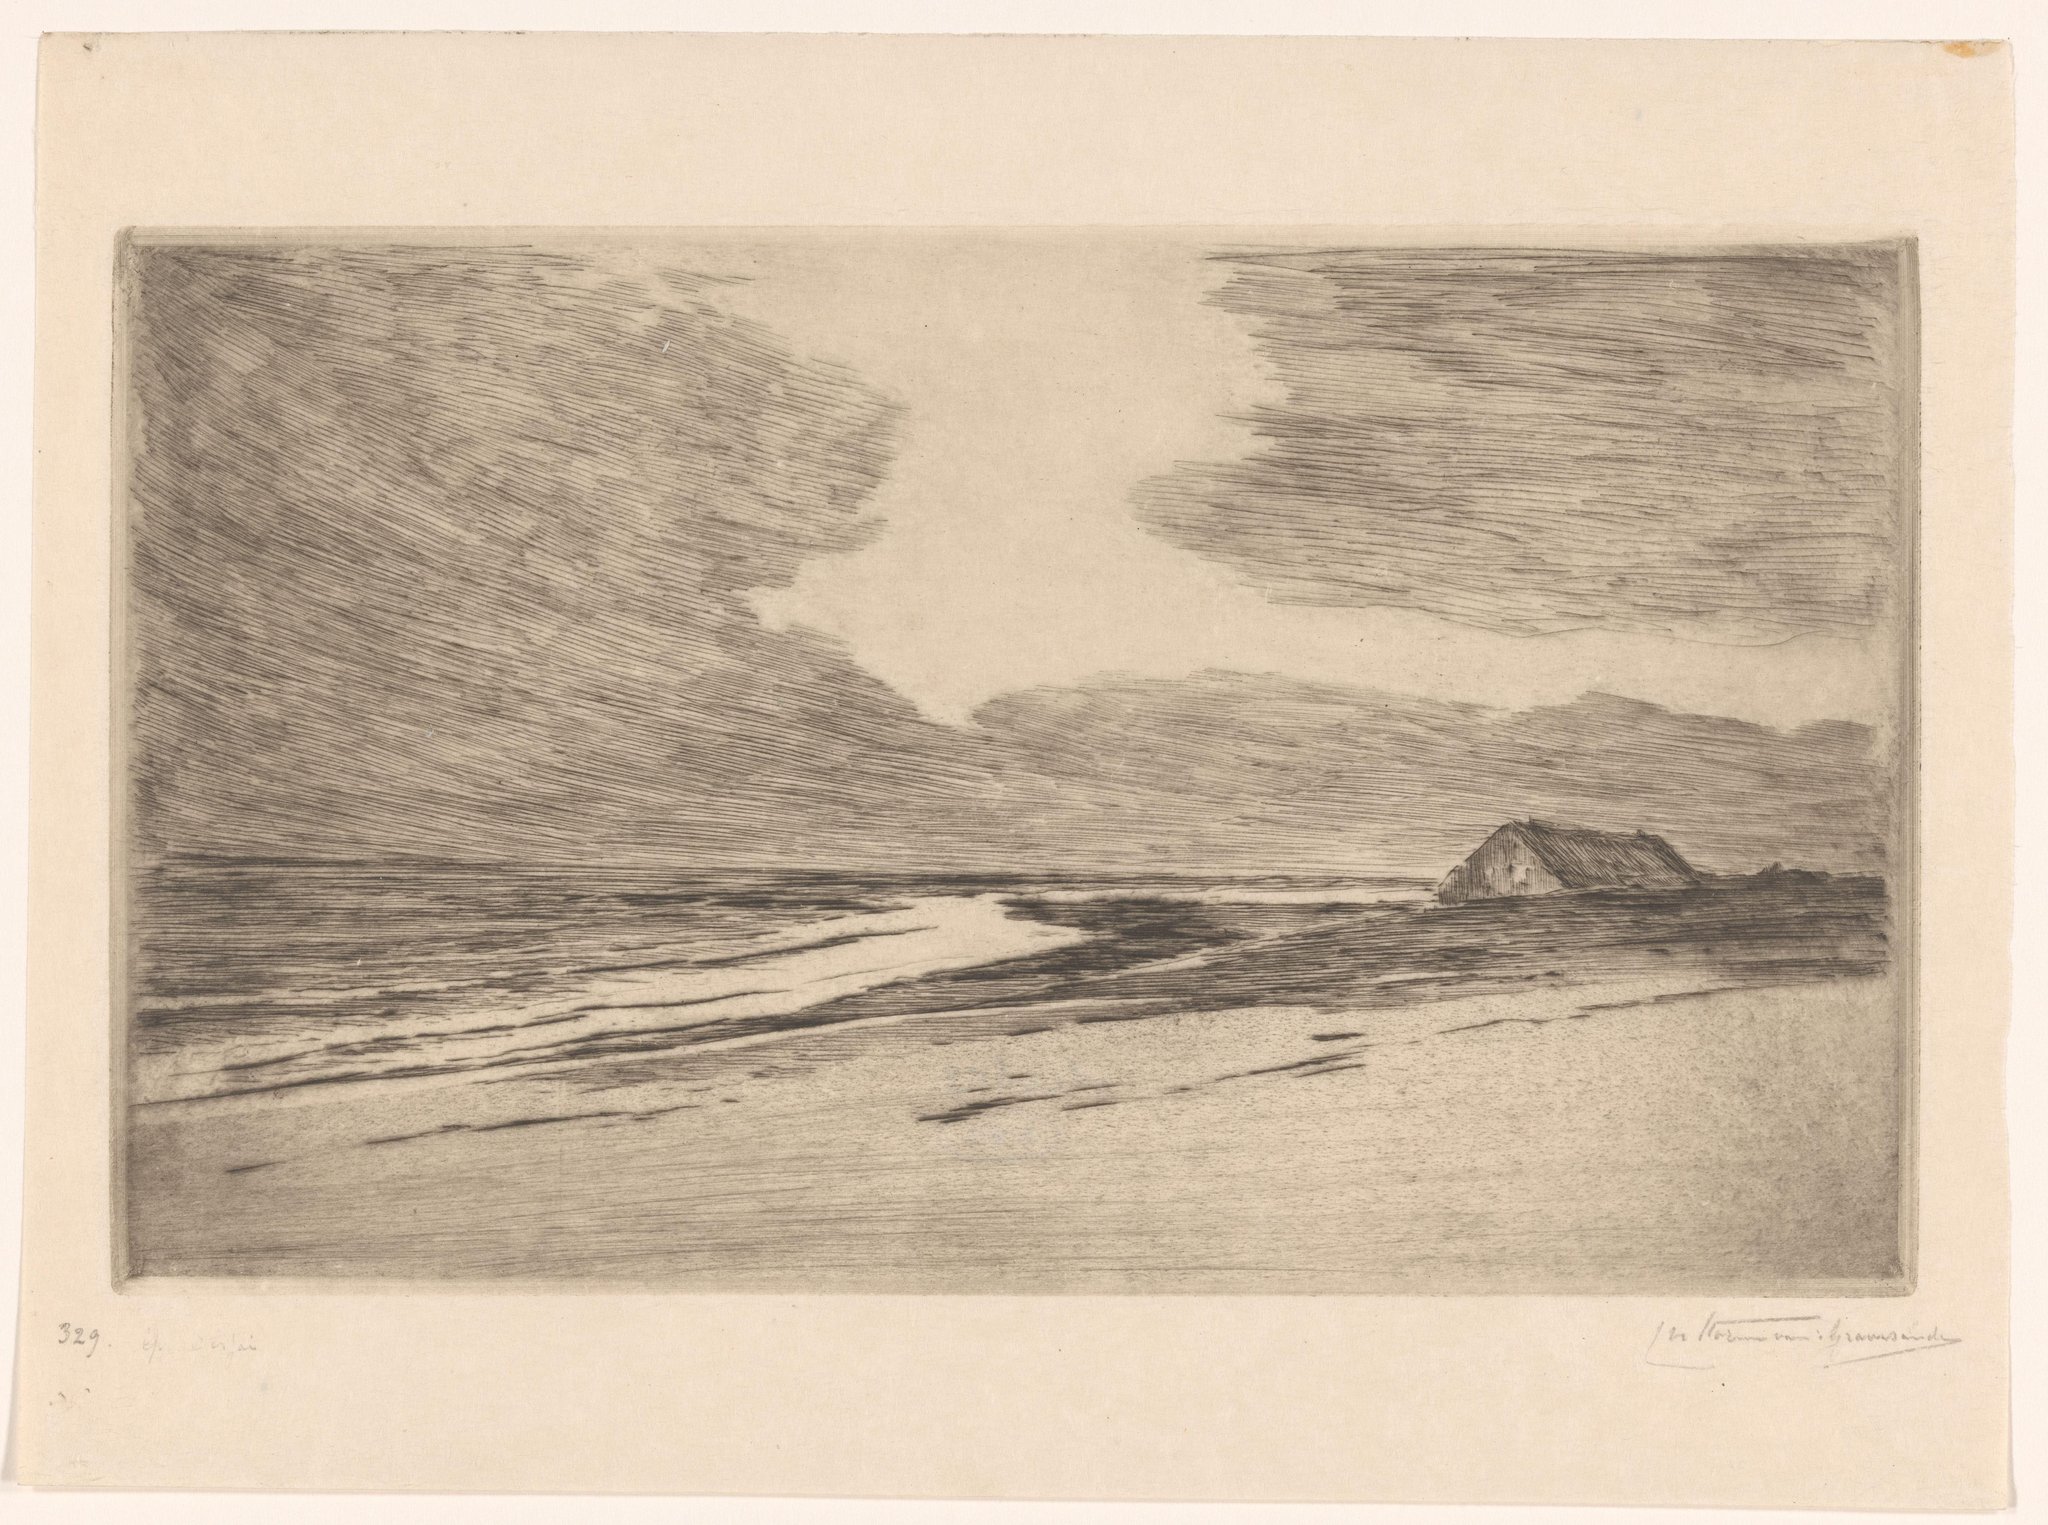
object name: print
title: Strandgezicht bij avond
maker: carel nicolaas storm van s-gravesande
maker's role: draughtsman, print maker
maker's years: 1841-1924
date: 1889-1902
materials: paper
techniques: drypoint, intaglio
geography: netherlands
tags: evening, beach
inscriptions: number: ‘329’, collector's mark: Lugt 2228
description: Mogelijk vermeld in: Storm van 's-Gravesande, Charles. Catalogue des eaux-fortes et lithographies. New York: s.n., 1903, of in een onbekende latere uitgave van het manuscript. Vermoedelijk vermeld als catalogusnummer 329.